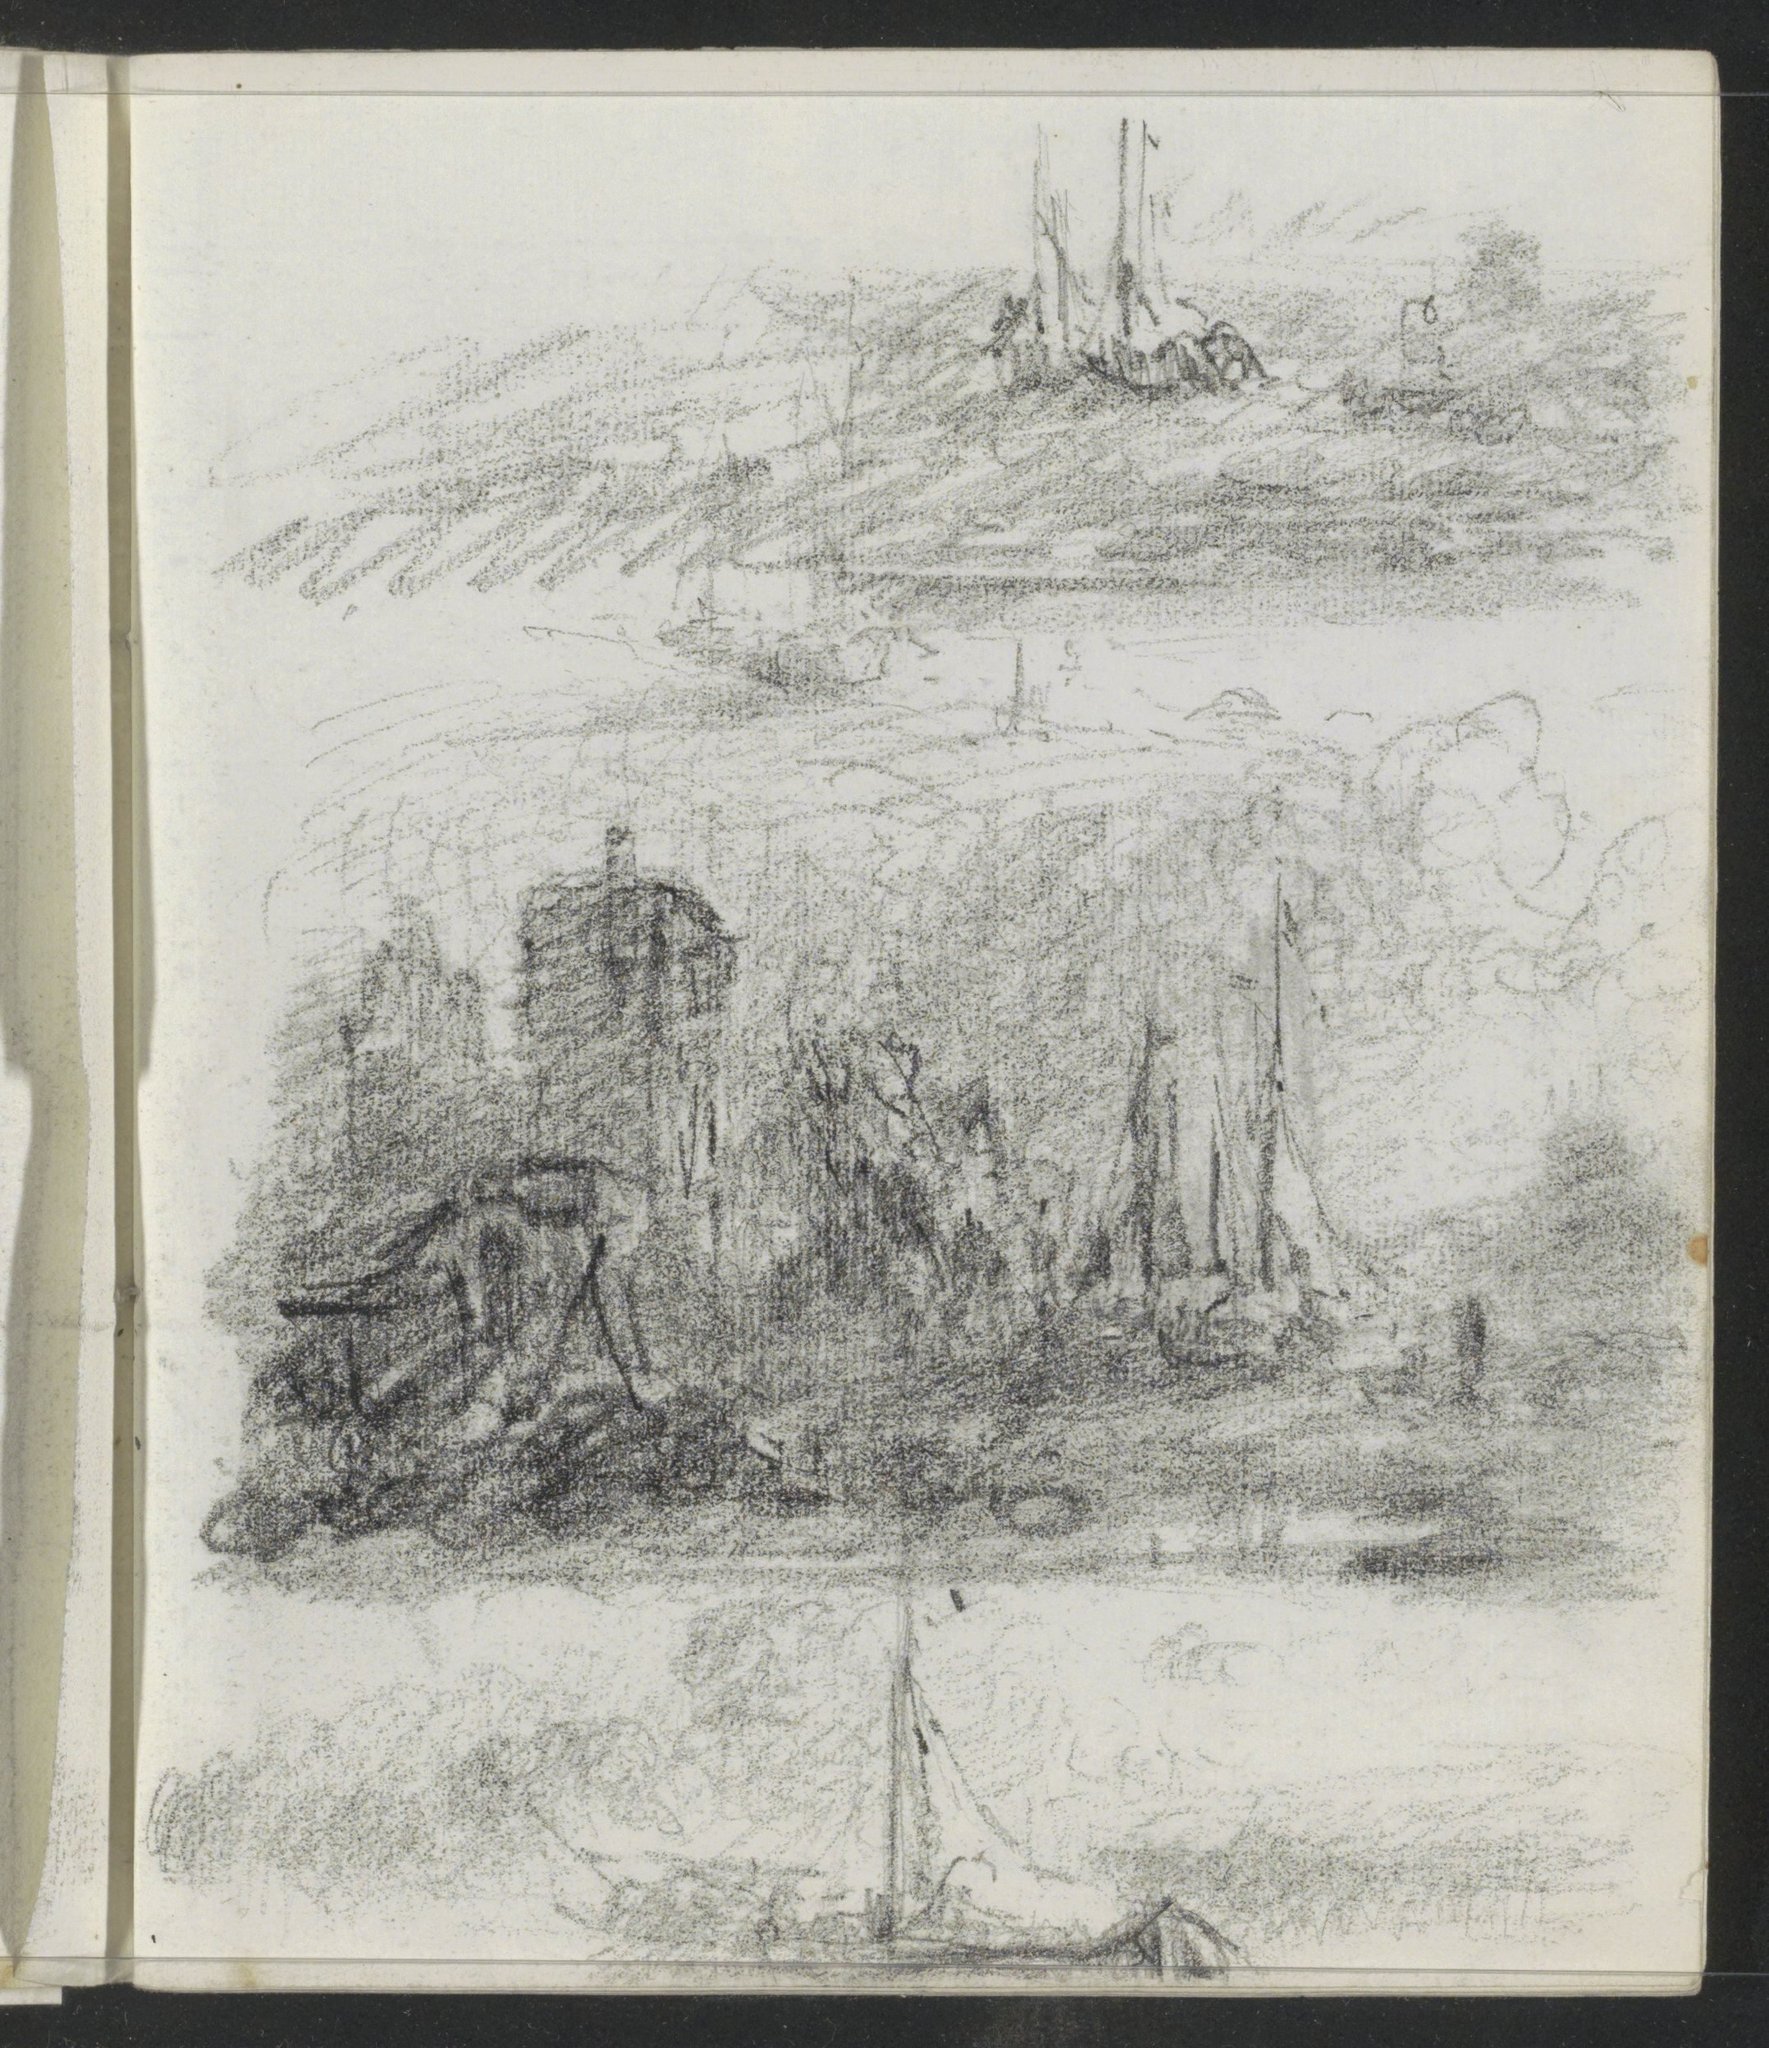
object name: sketchbook leaf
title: Zeilschepen op open water en zeilschepen bij een kustlijn met huizen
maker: maria vos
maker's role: draughtsman, painter, print maker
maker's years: 1824-1906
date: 1834-1906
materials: paper, pencil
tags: sailing-ship, sailing-boat, landscapes with waters, waterscapes, seascapes (in the temperate zone)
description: Blad 4 recto uit een schetsboek met 20 bladen.